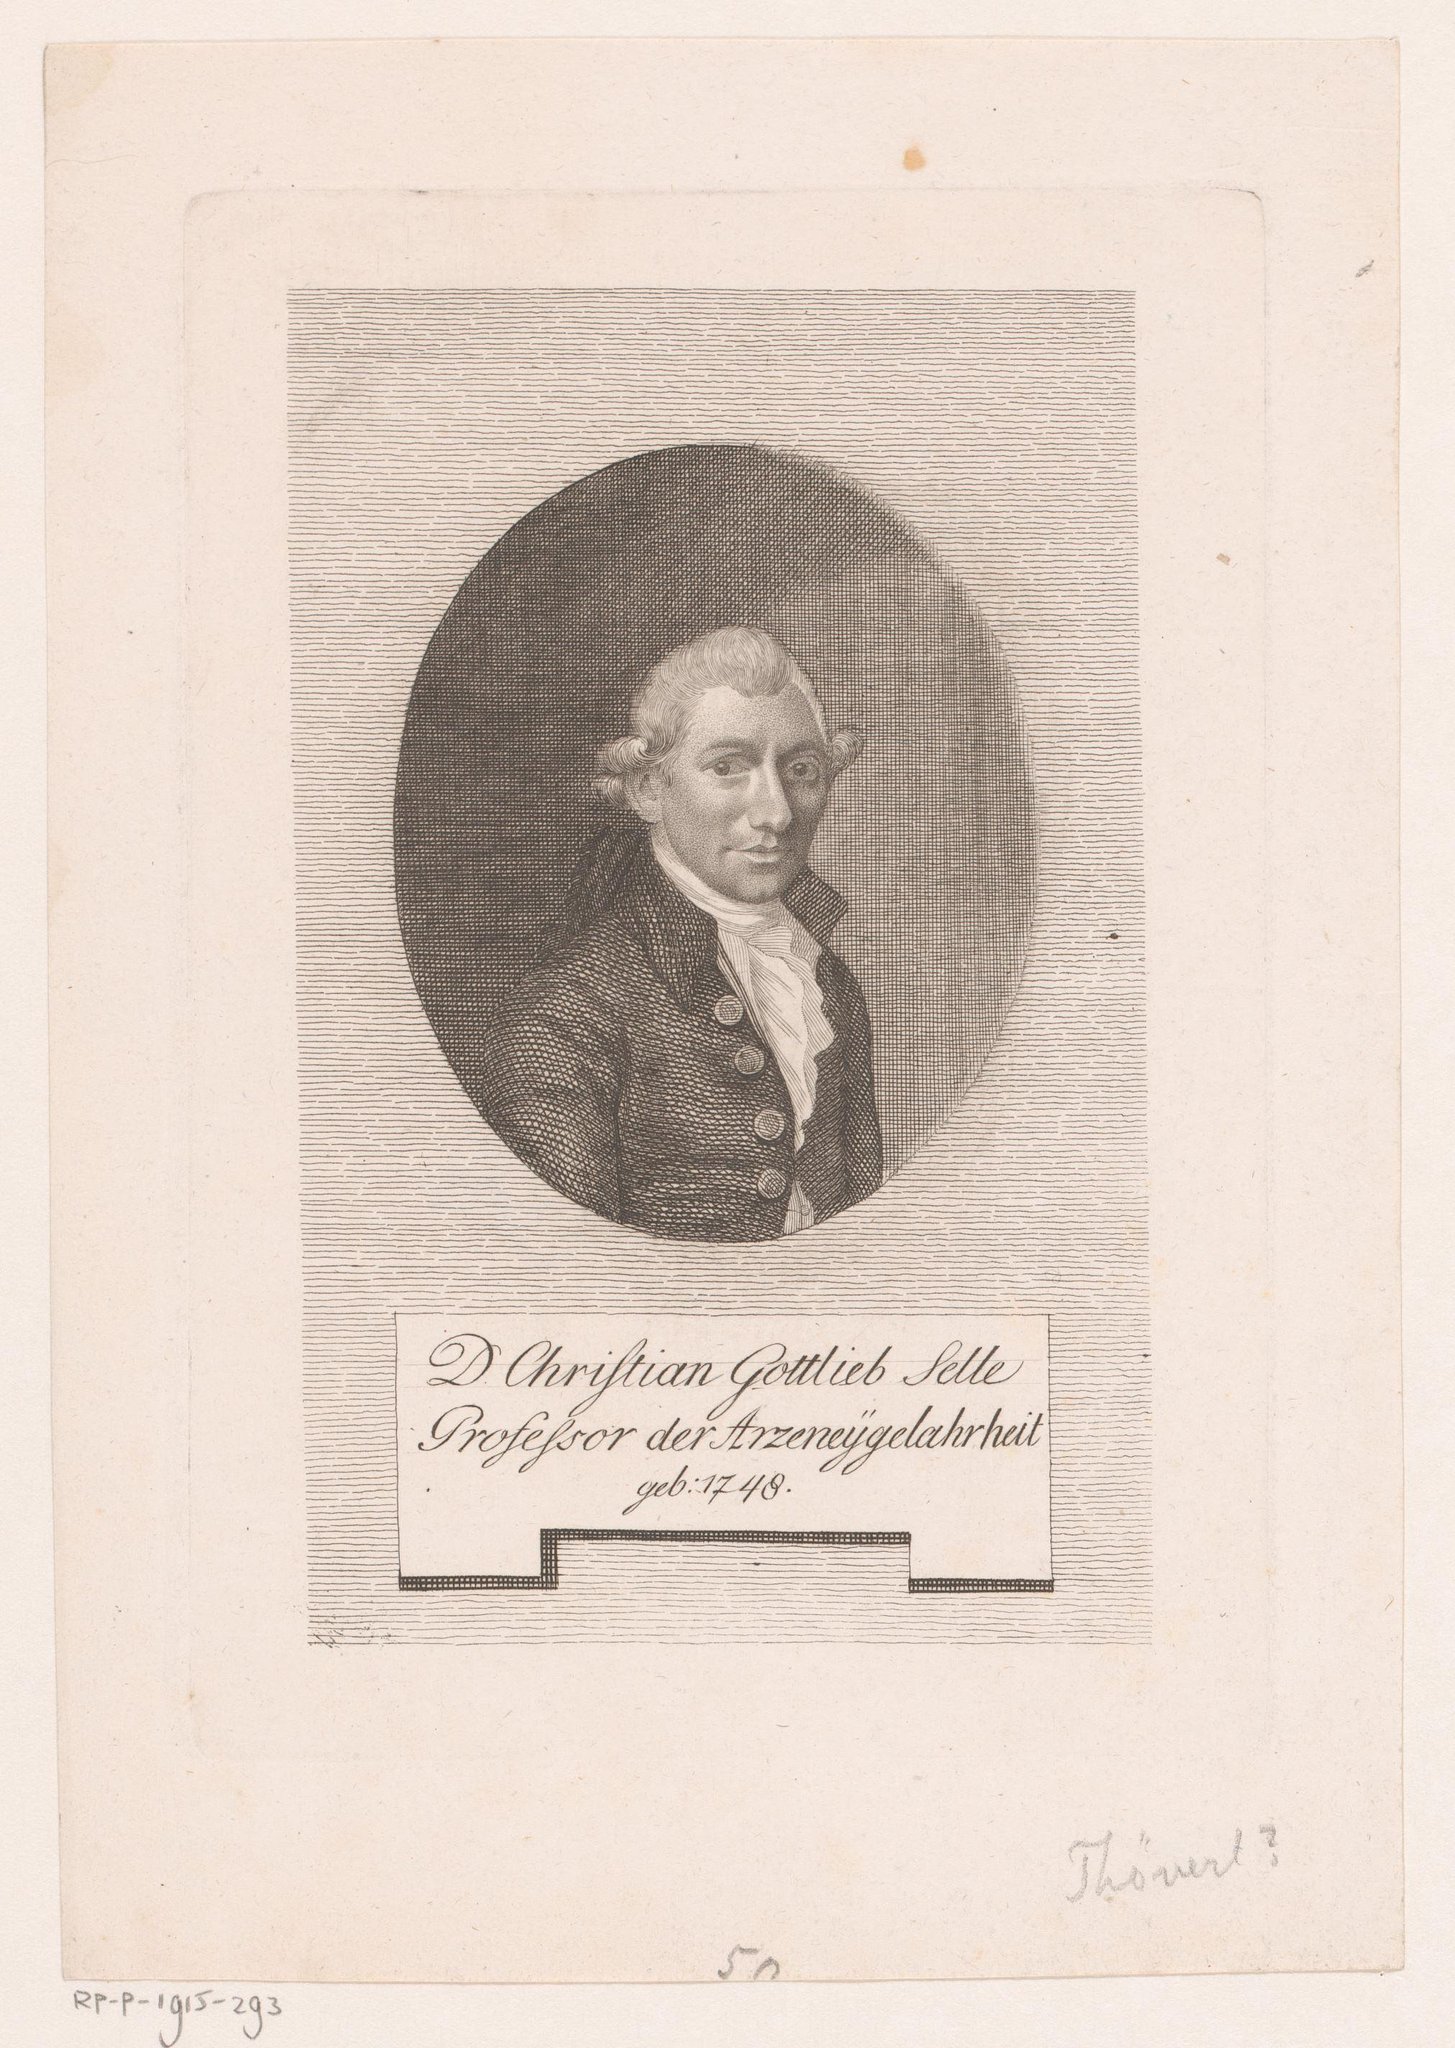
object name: print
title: Portret van Christian Gottlieb Selle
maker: eberhard siegfried henne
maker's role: print maker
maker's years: 1759-1828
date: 1780-1814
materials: paper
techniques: etching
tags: berlin, christian gottlieb selle, historical persons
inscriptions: collector's mark: Lugt 2228